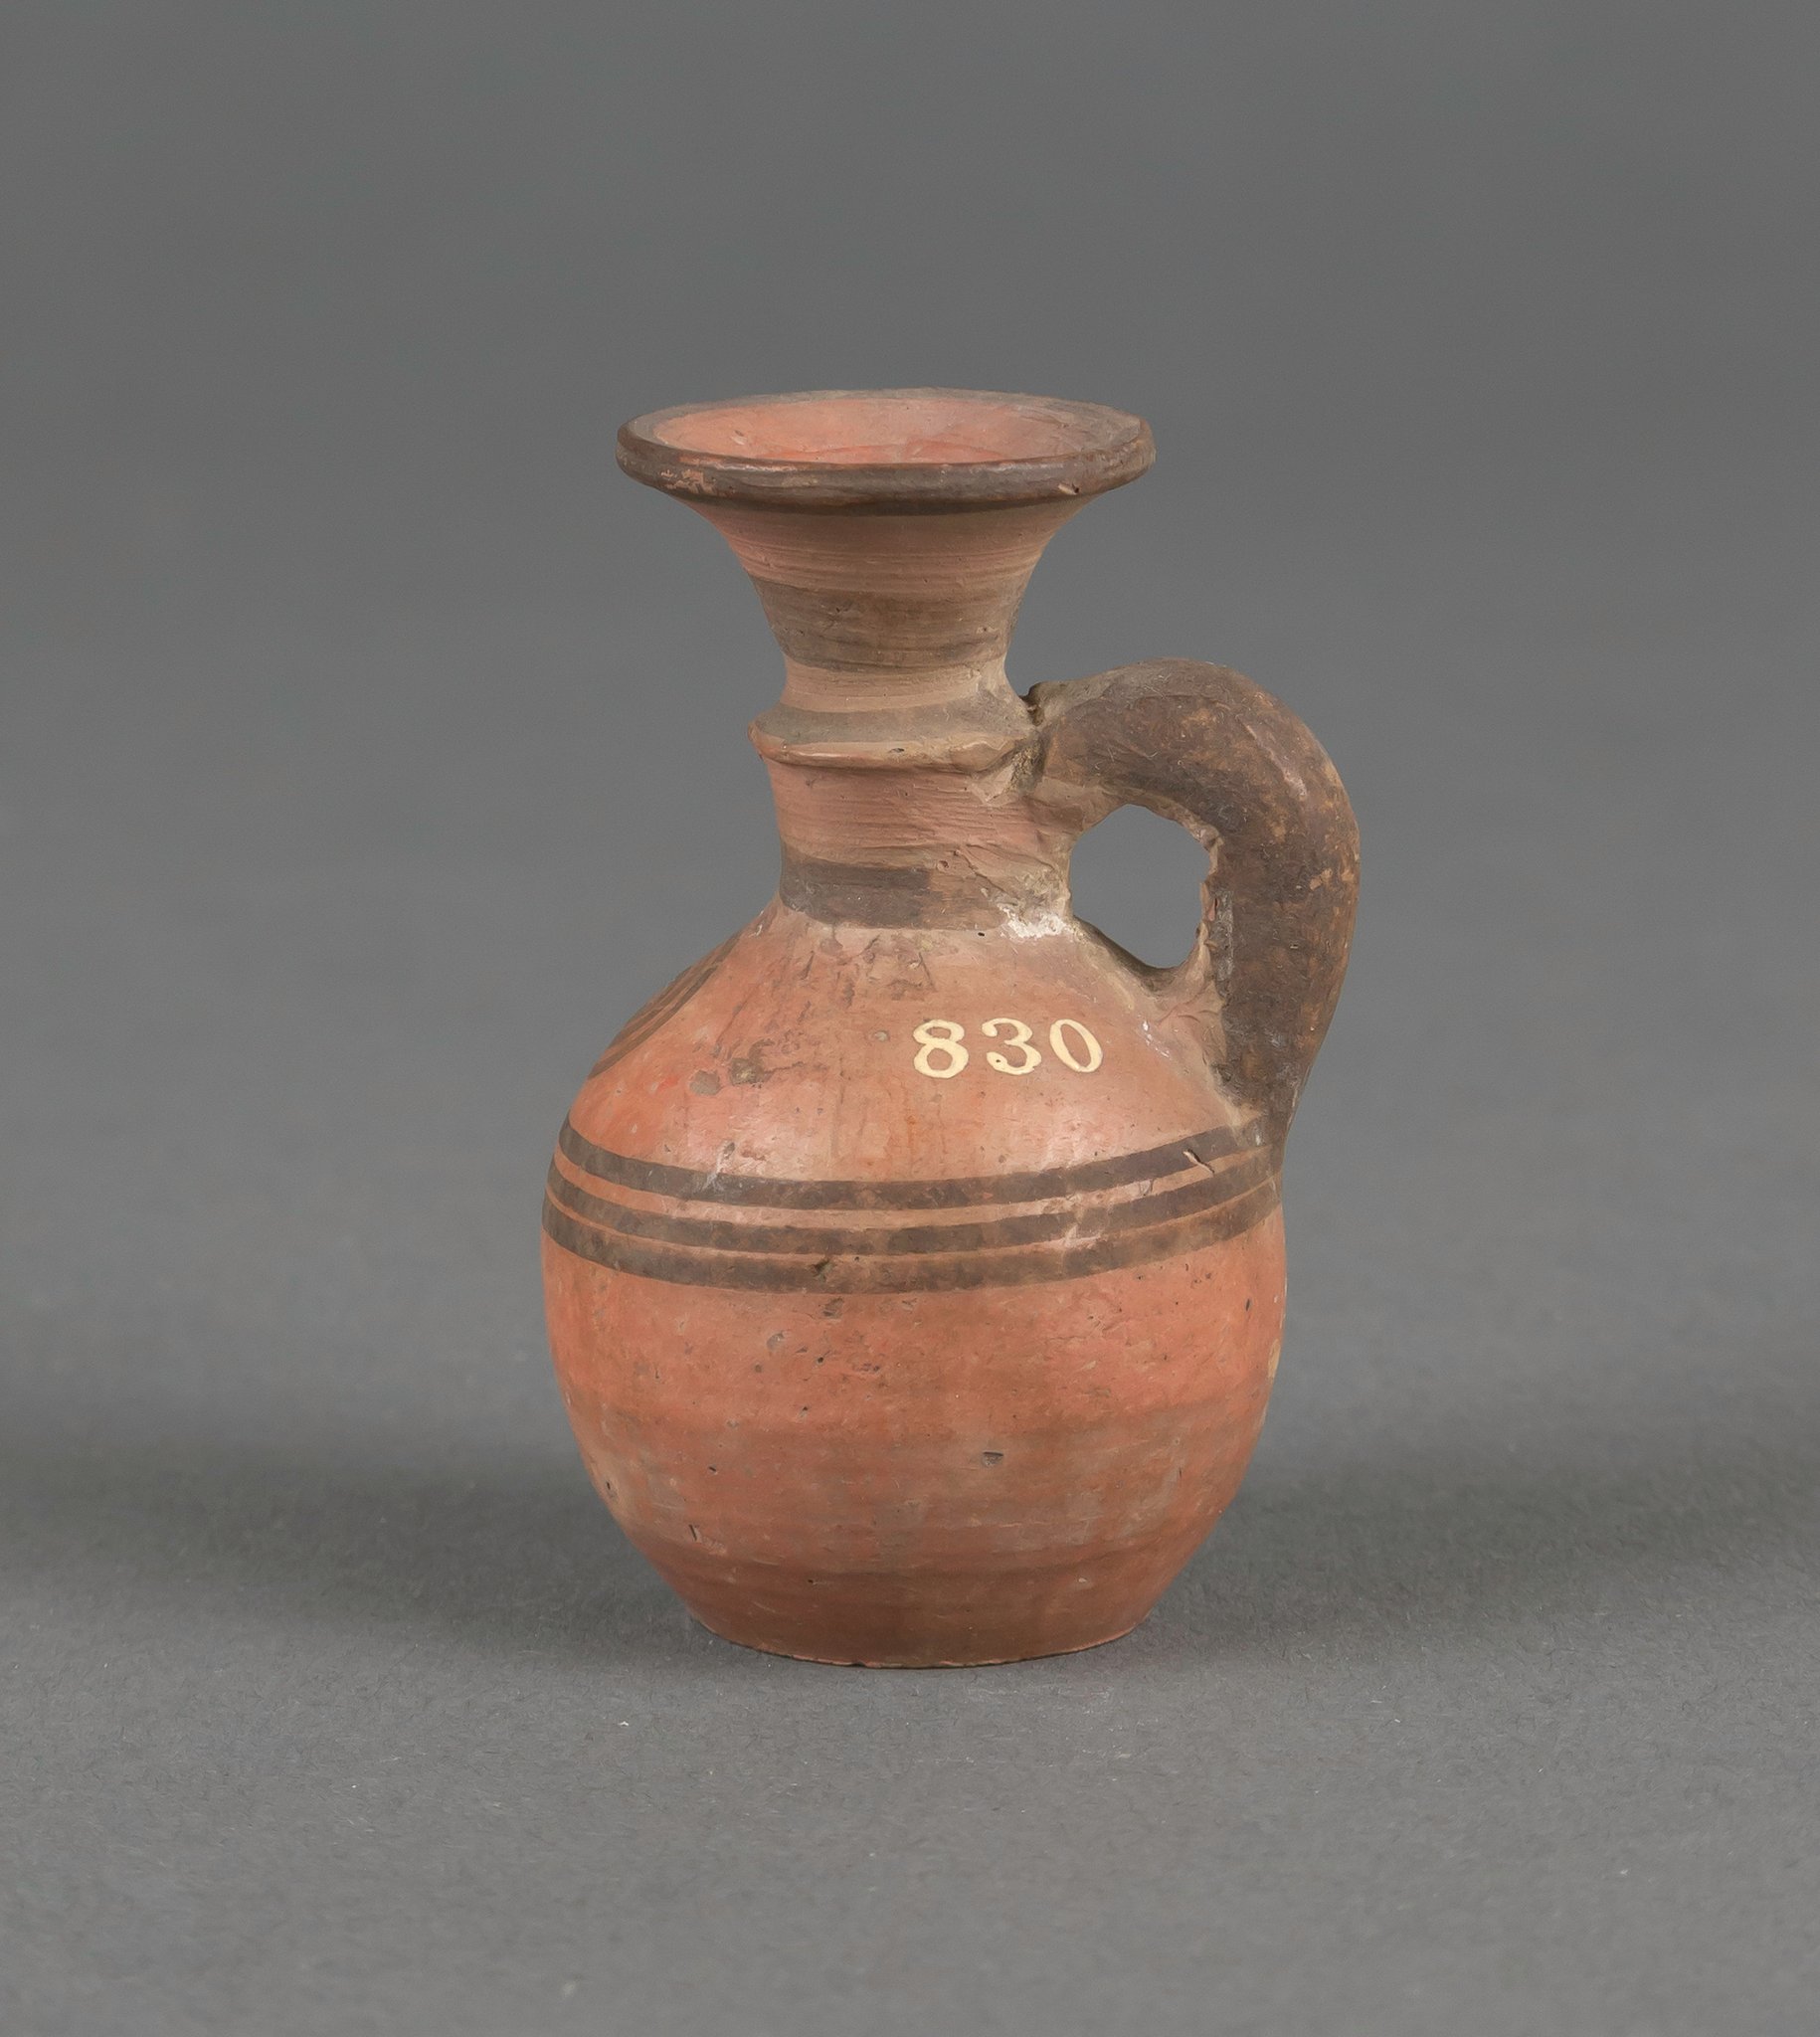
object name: jug, miniature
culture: cypriot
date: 1050-900 BCE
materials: terracotta